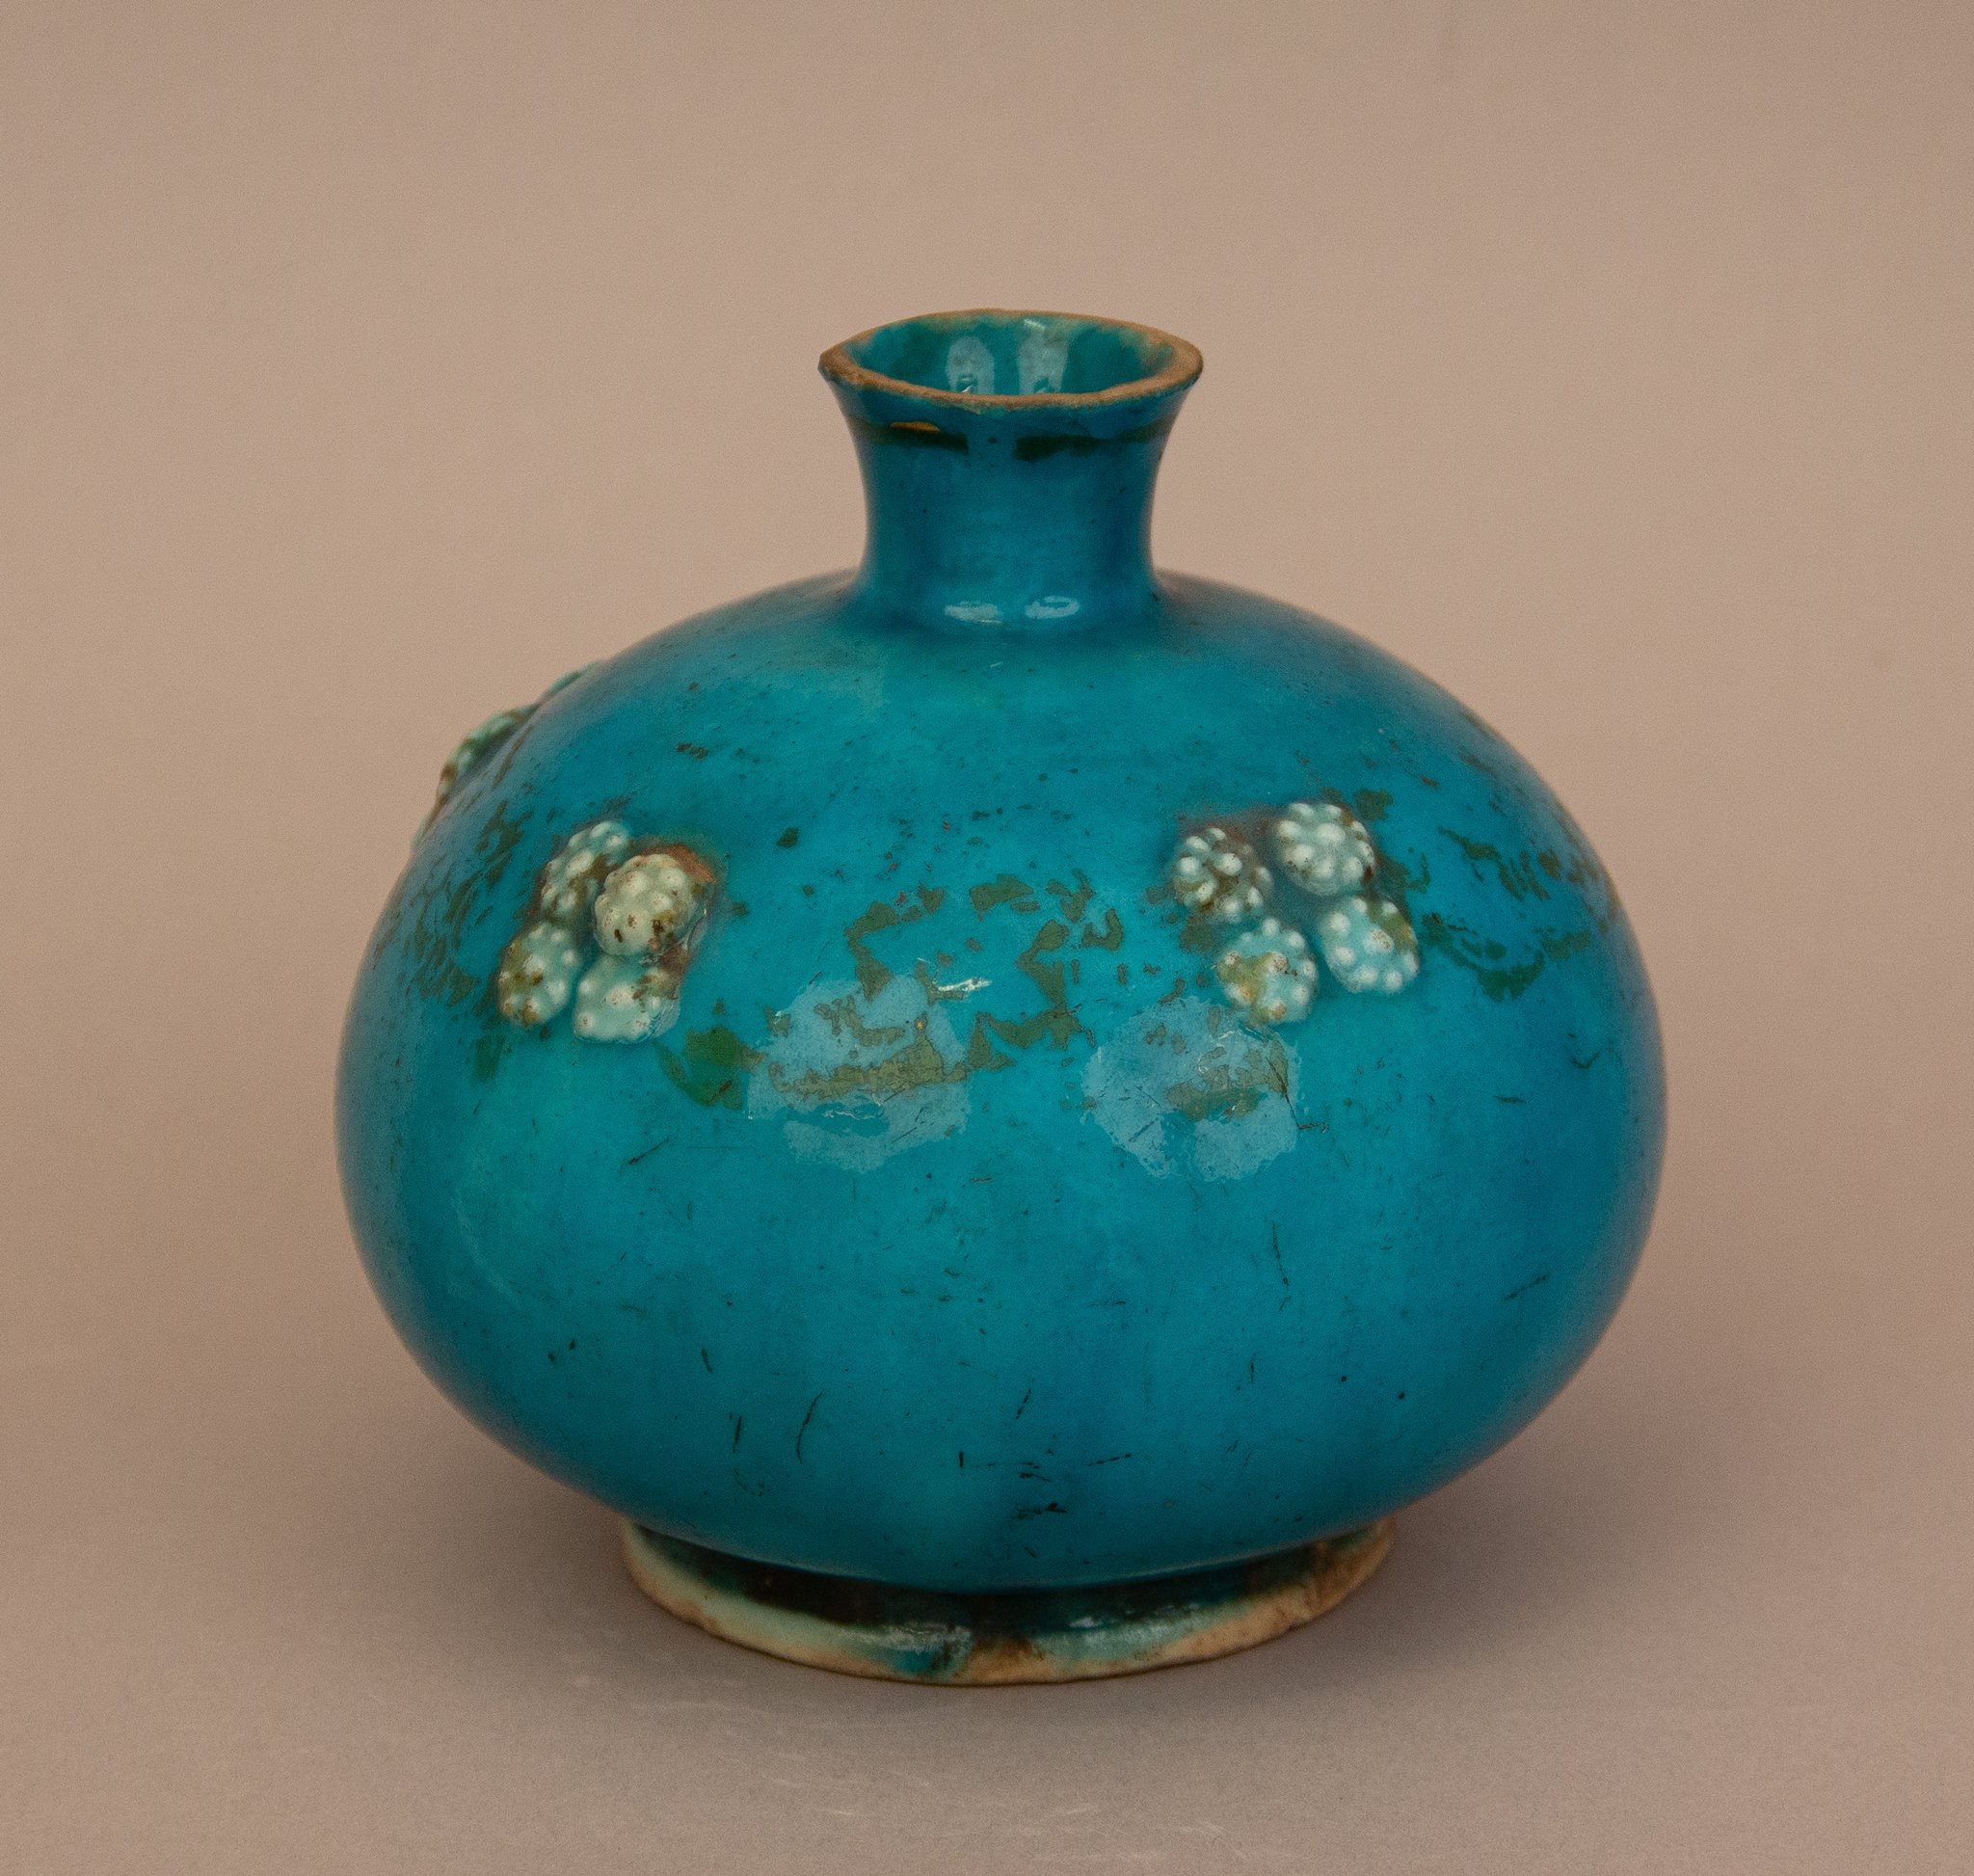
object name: vase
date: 1601-1700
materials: pottery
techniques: glazing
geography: iran